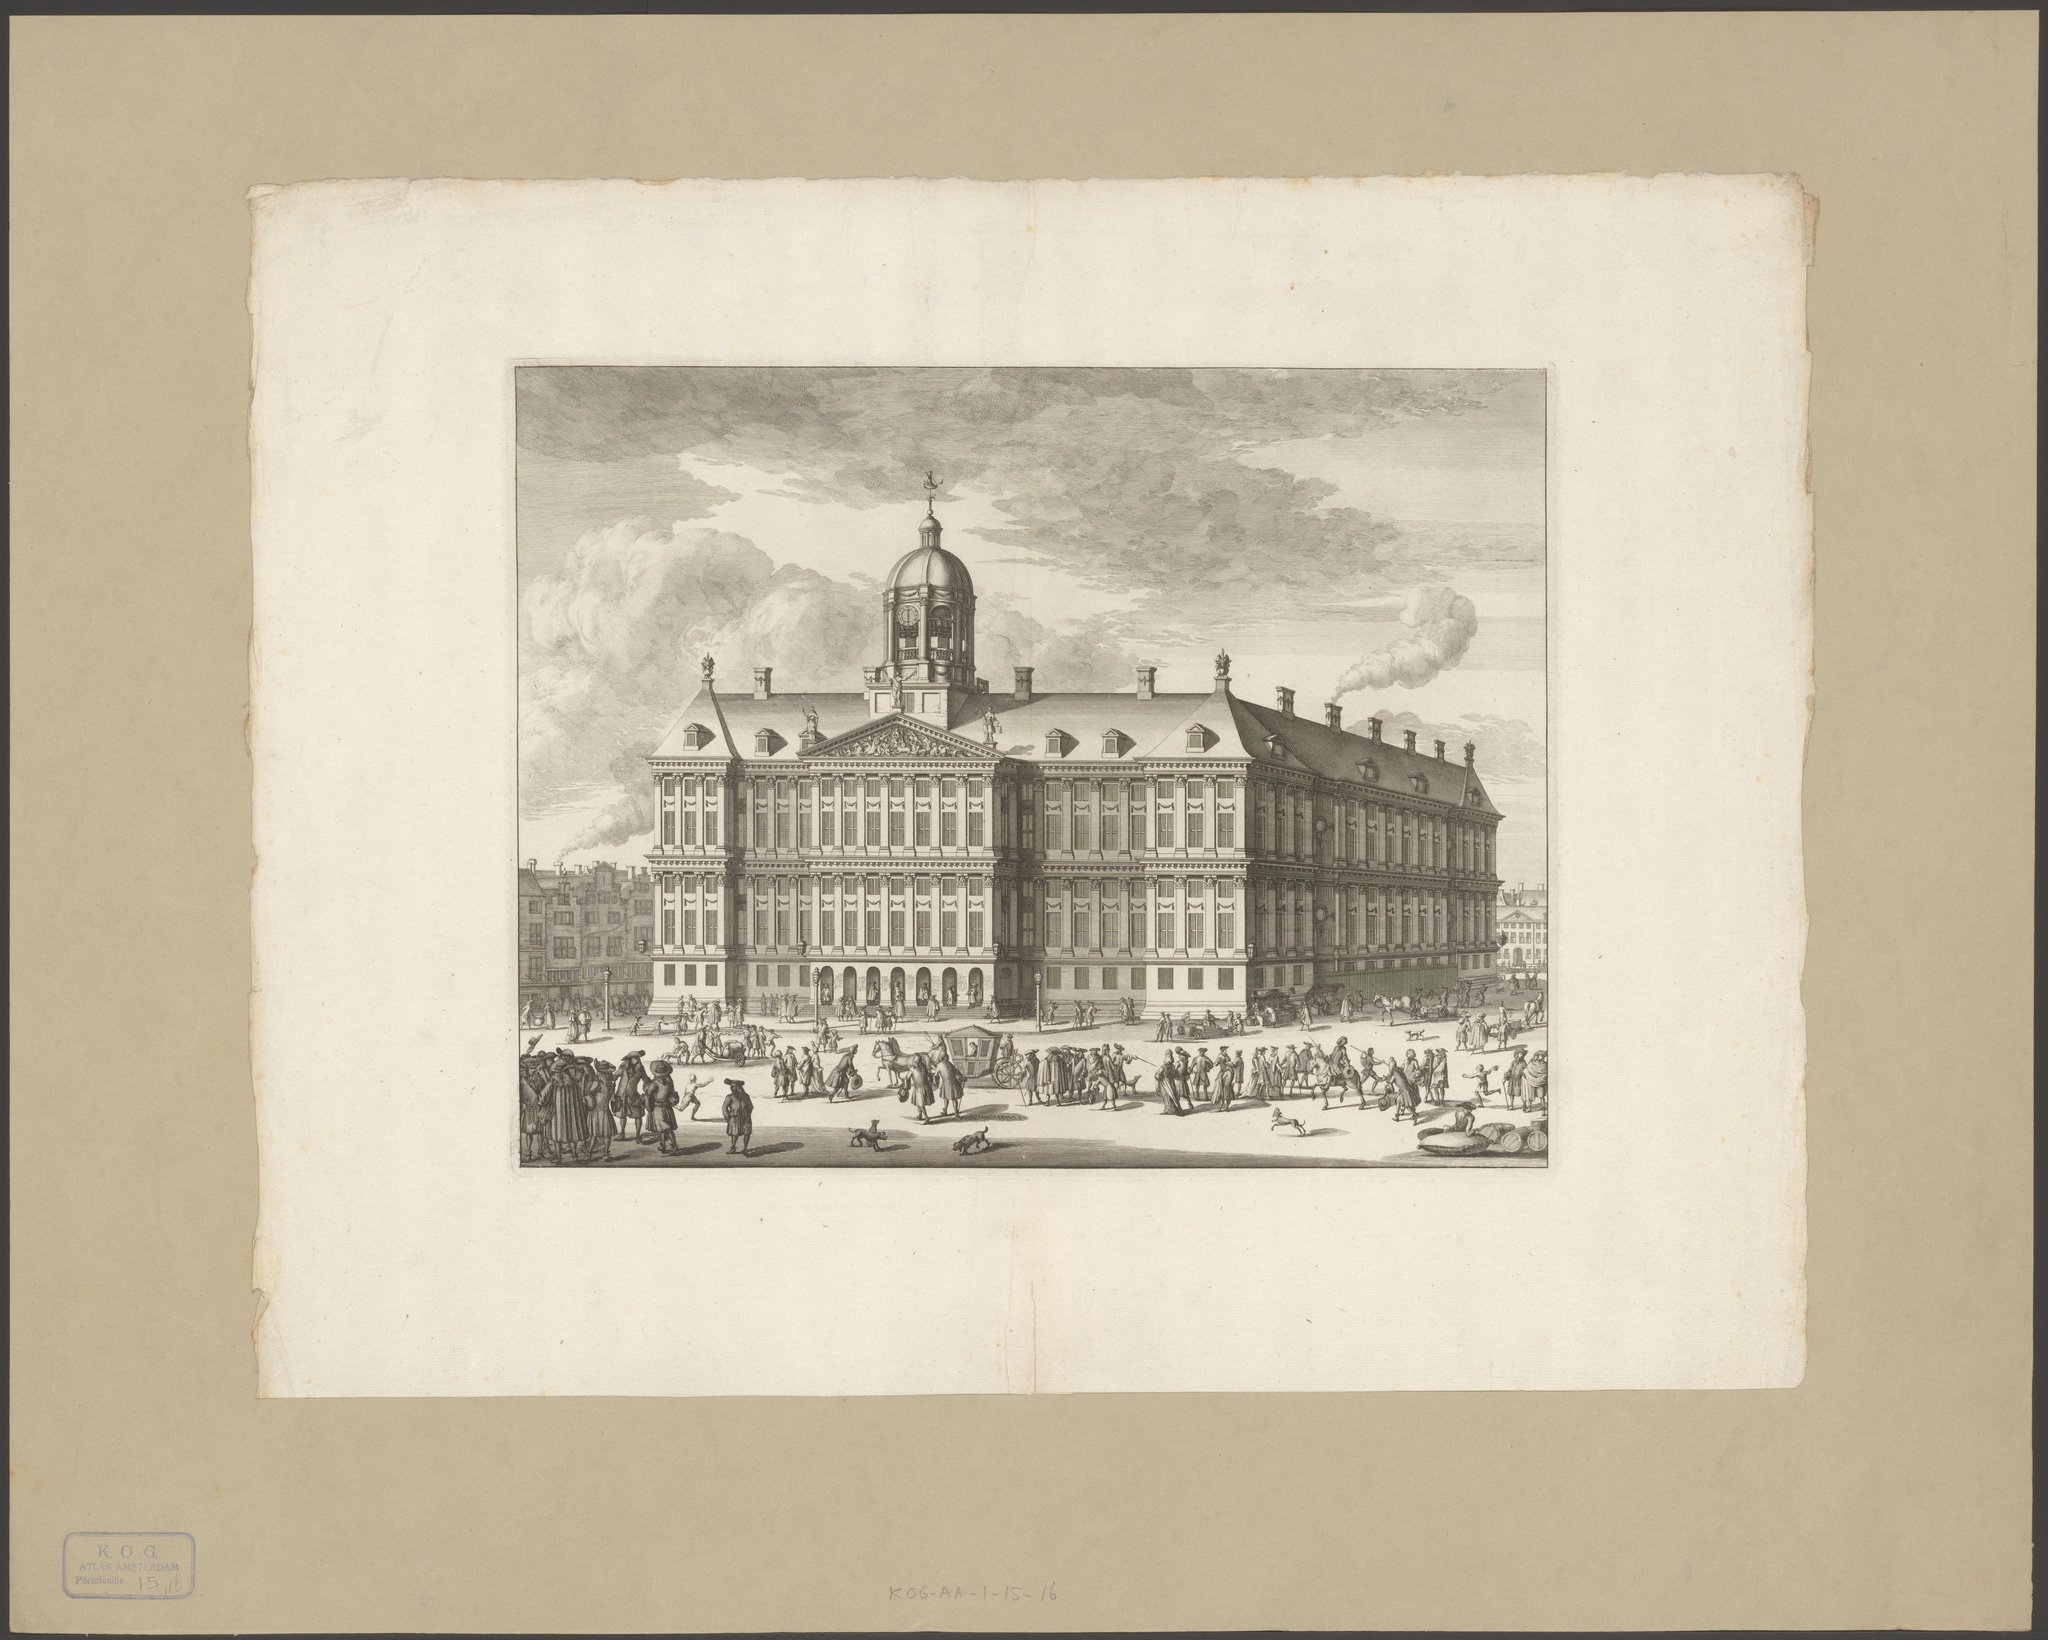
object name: print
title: Gezicht op het Stadhuis op de Dam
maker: Anonymous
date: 1693-1726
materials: paper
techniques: engraving, etching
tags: city-view in general; 'veduta', townhall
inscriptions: collector's mark: ‘15,16’ Lugt 1641b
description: Andere staten van prent gebruikt in: Commelin, Caspar. Beschryvinge van Amsterdam, desselfs eerste oorspronk uyt den Huyse (…). 2 delen. Amsterdam: Abraham Wolfgang, Gillis Janssonius van Waesberge, Johannes Janssonius van Waesberge II, weduwe Dirk Boom I, Hendrick Boom en Rembertus Goethals, 1693. En in: Commelin, Caspar. Beschryvinge van Amsterdam, zynde een naukeurige verhandelinge van desselfs eerste oorspronk uyt (…). 2 delen. Amsterdam: weduwe Aart Dircksz Oossaan, 1694. En in: Commelin, Caspar. Beschryvinge van Amsterdam, zynde een naukeurige verhandelinge van desselfs eerste oorspronk uyt (…). 2 delen. 2e druk. Amsterdam: Andries van Damme, Johannes Ratelband, weduwe A. van Aaltwyk en Hermanus Uytwerf, 1726.